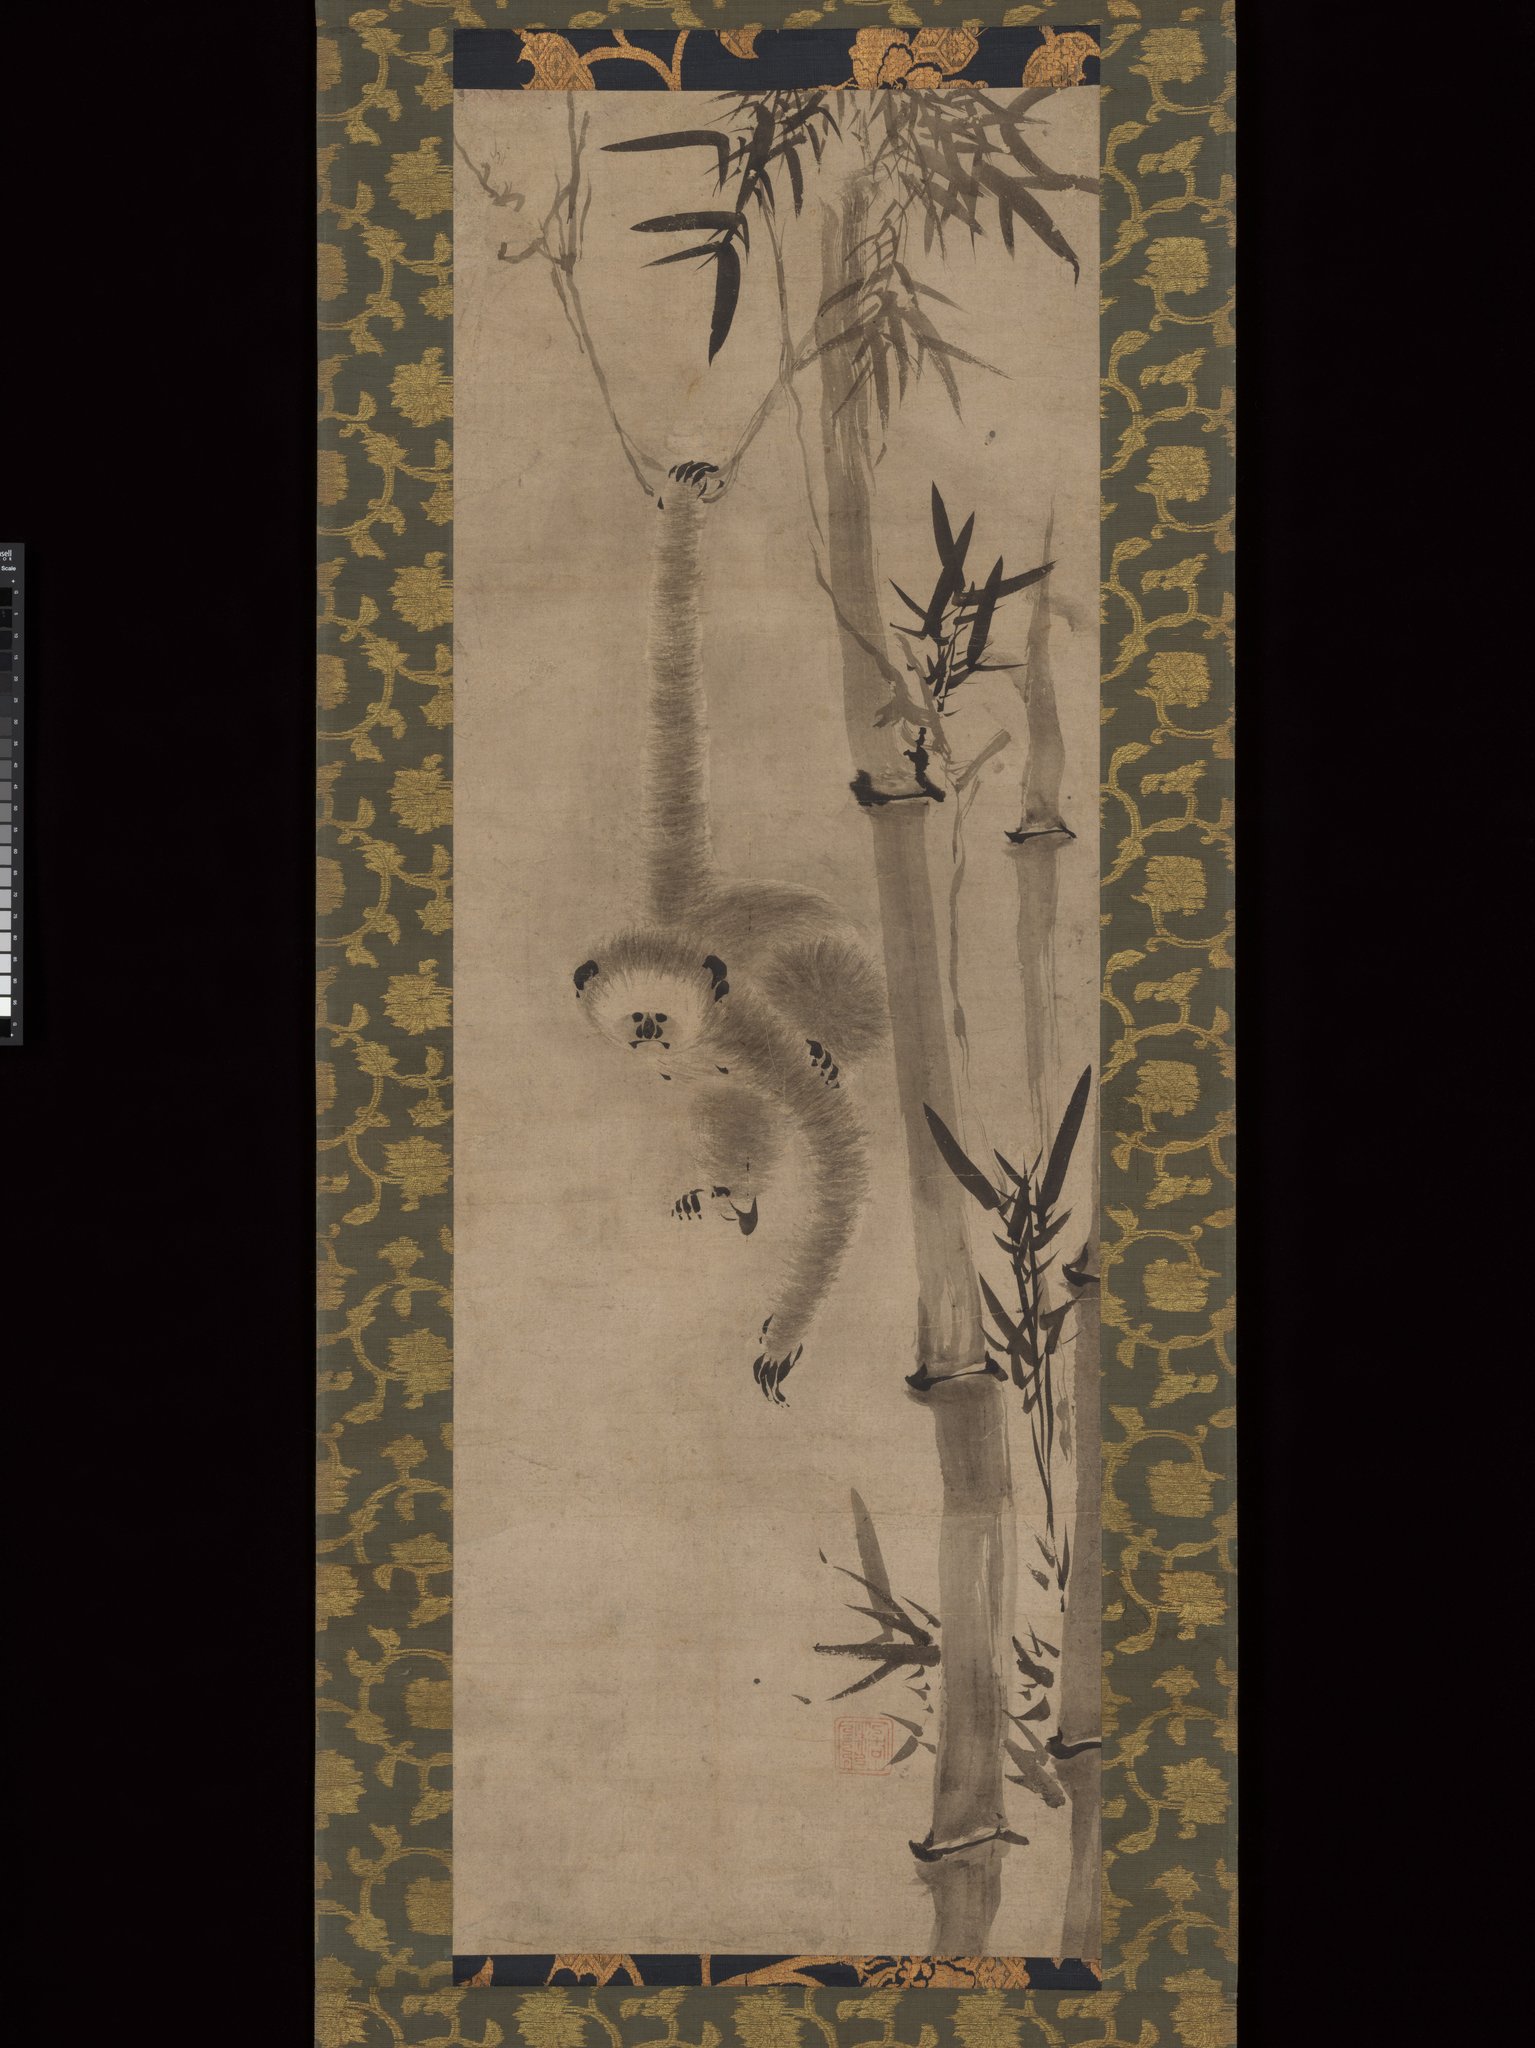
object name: hanging scroll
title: Gibbon and Bamboo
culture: japanese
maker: sesson shūkei 雪村周継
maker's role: artist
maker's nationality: japanese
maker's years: 1504-1589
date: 1501-1600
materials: ink, paper